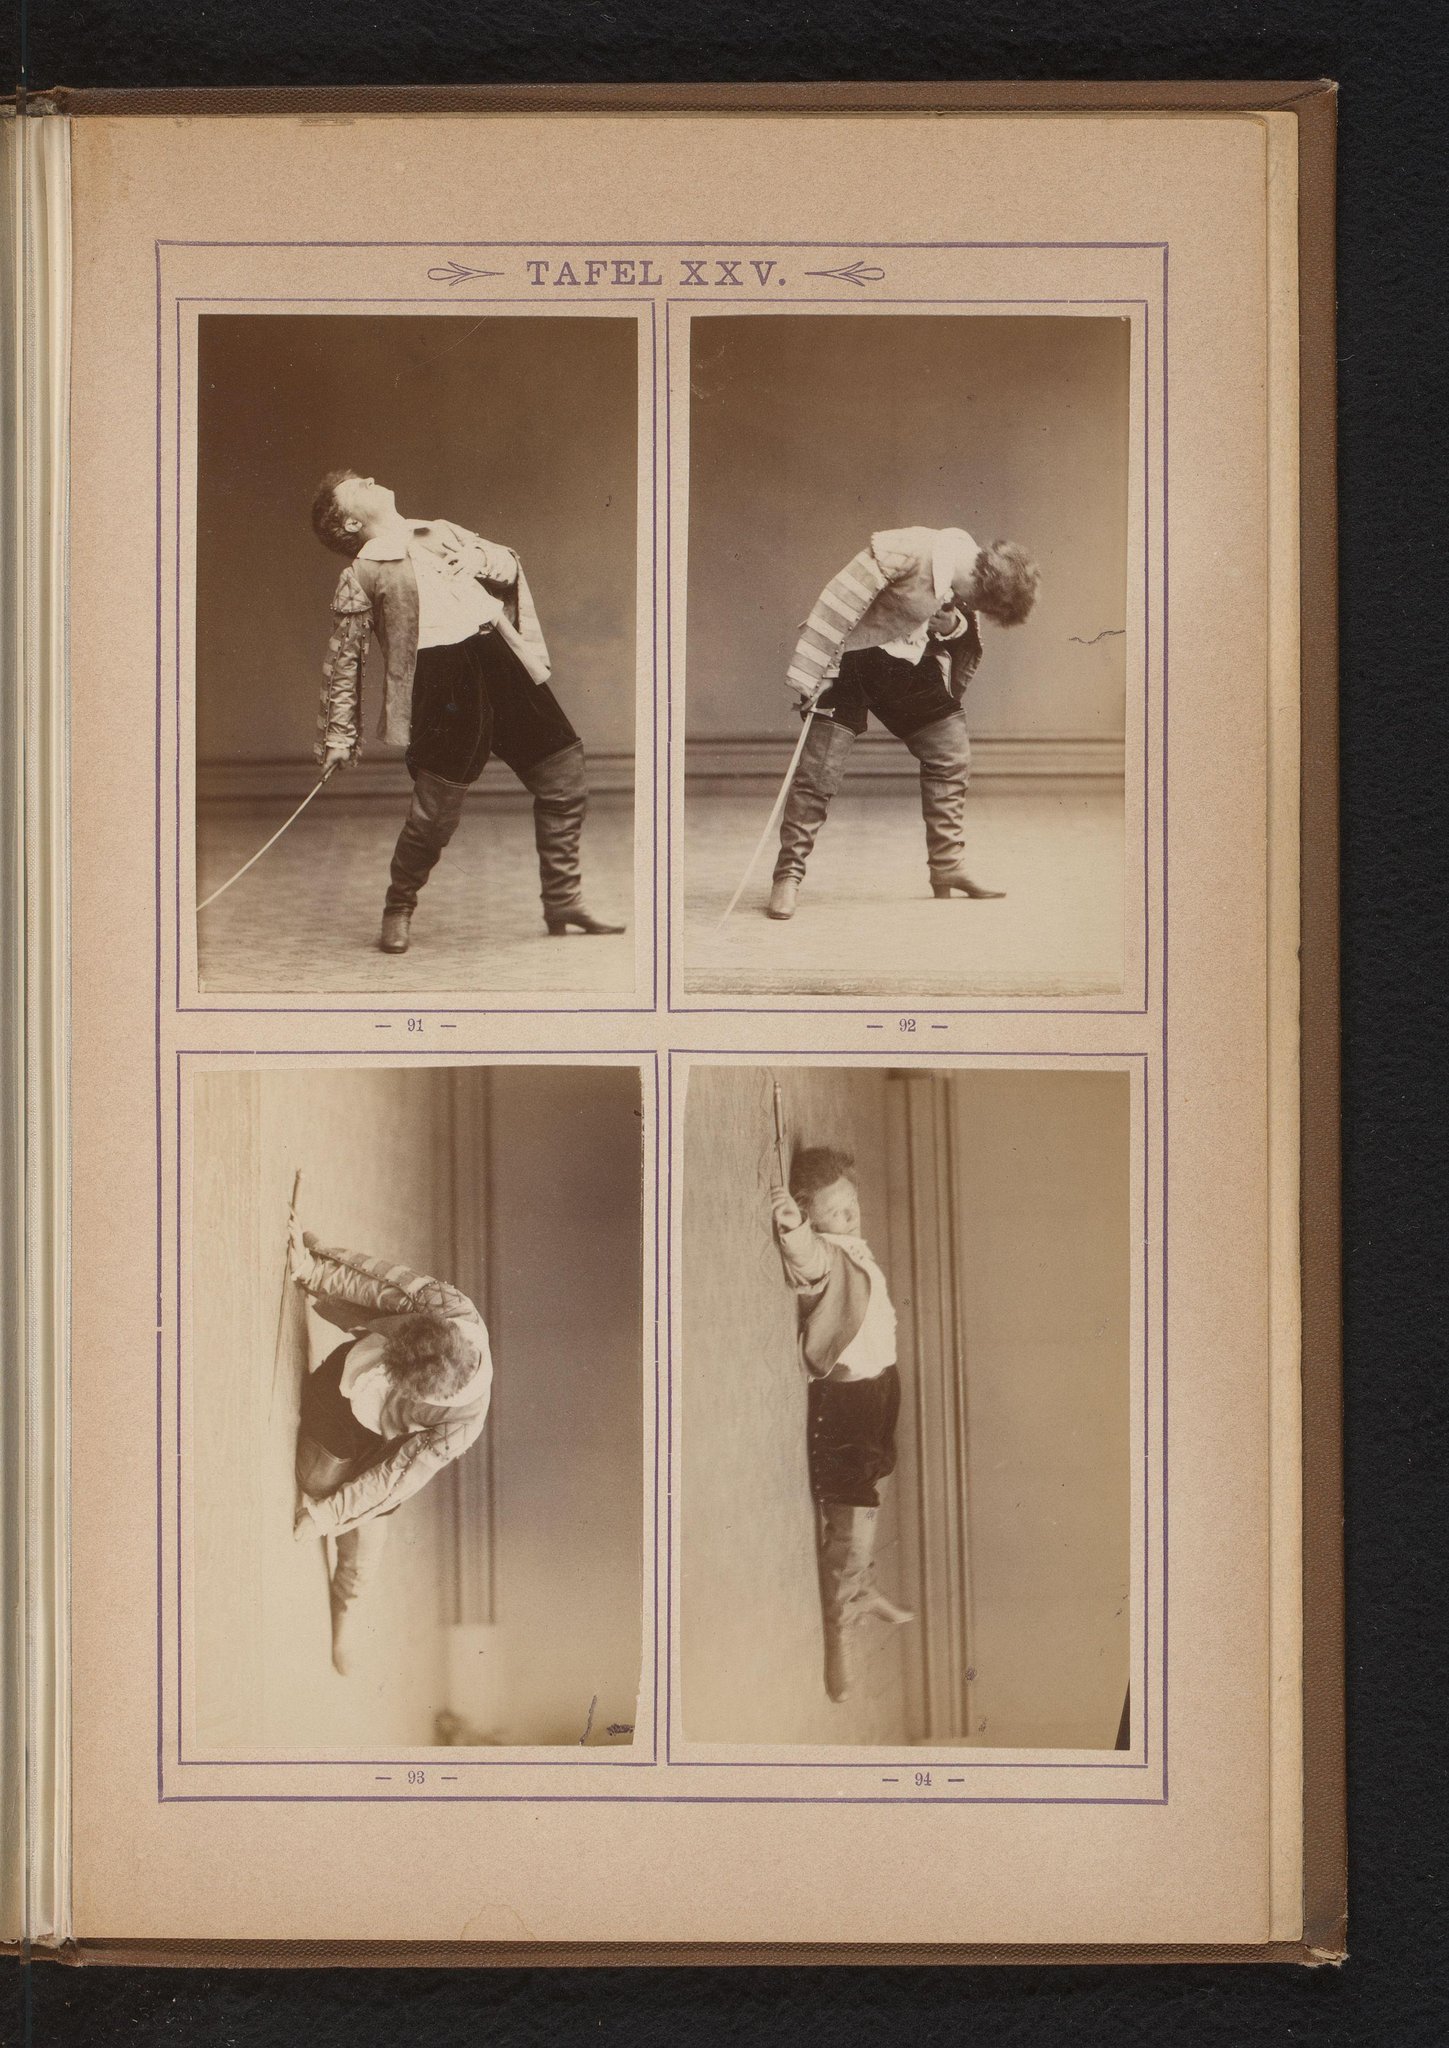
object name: photograph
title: Vier portretten van een man, voorstellende een dood tijdens een duel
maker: nicola tonger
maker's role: fotograaf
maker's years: 1846-1917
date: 1881-1886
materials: paper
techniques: albumen print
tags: morphology of facial expression, duelling, death of human being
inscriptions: number: ‘88 - 90’, number: ‘TAFEL XXV.’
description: Foto op negenenveertigste ongenummerde pagina na pagina 6.